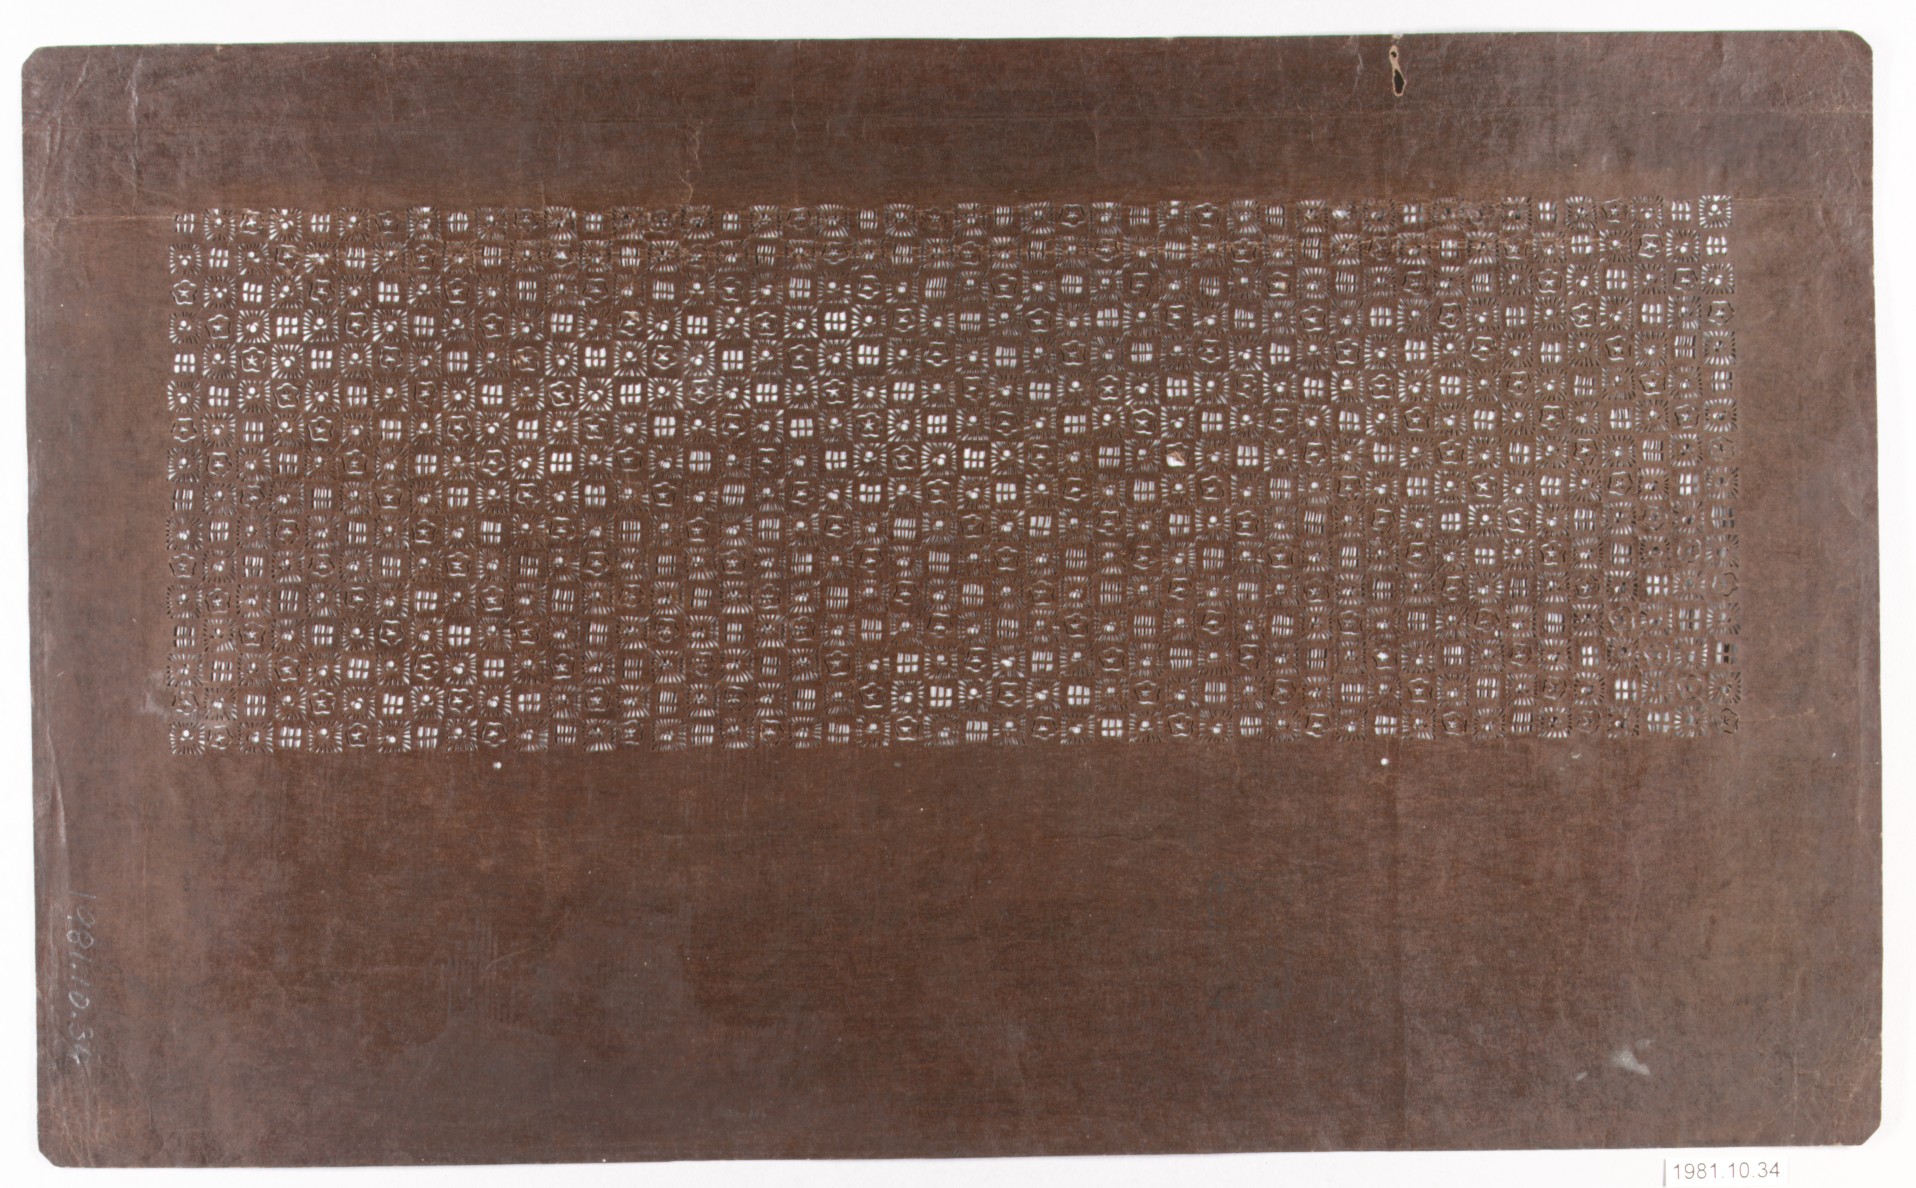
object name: stencil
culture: japanese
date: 1801-1900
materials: paper